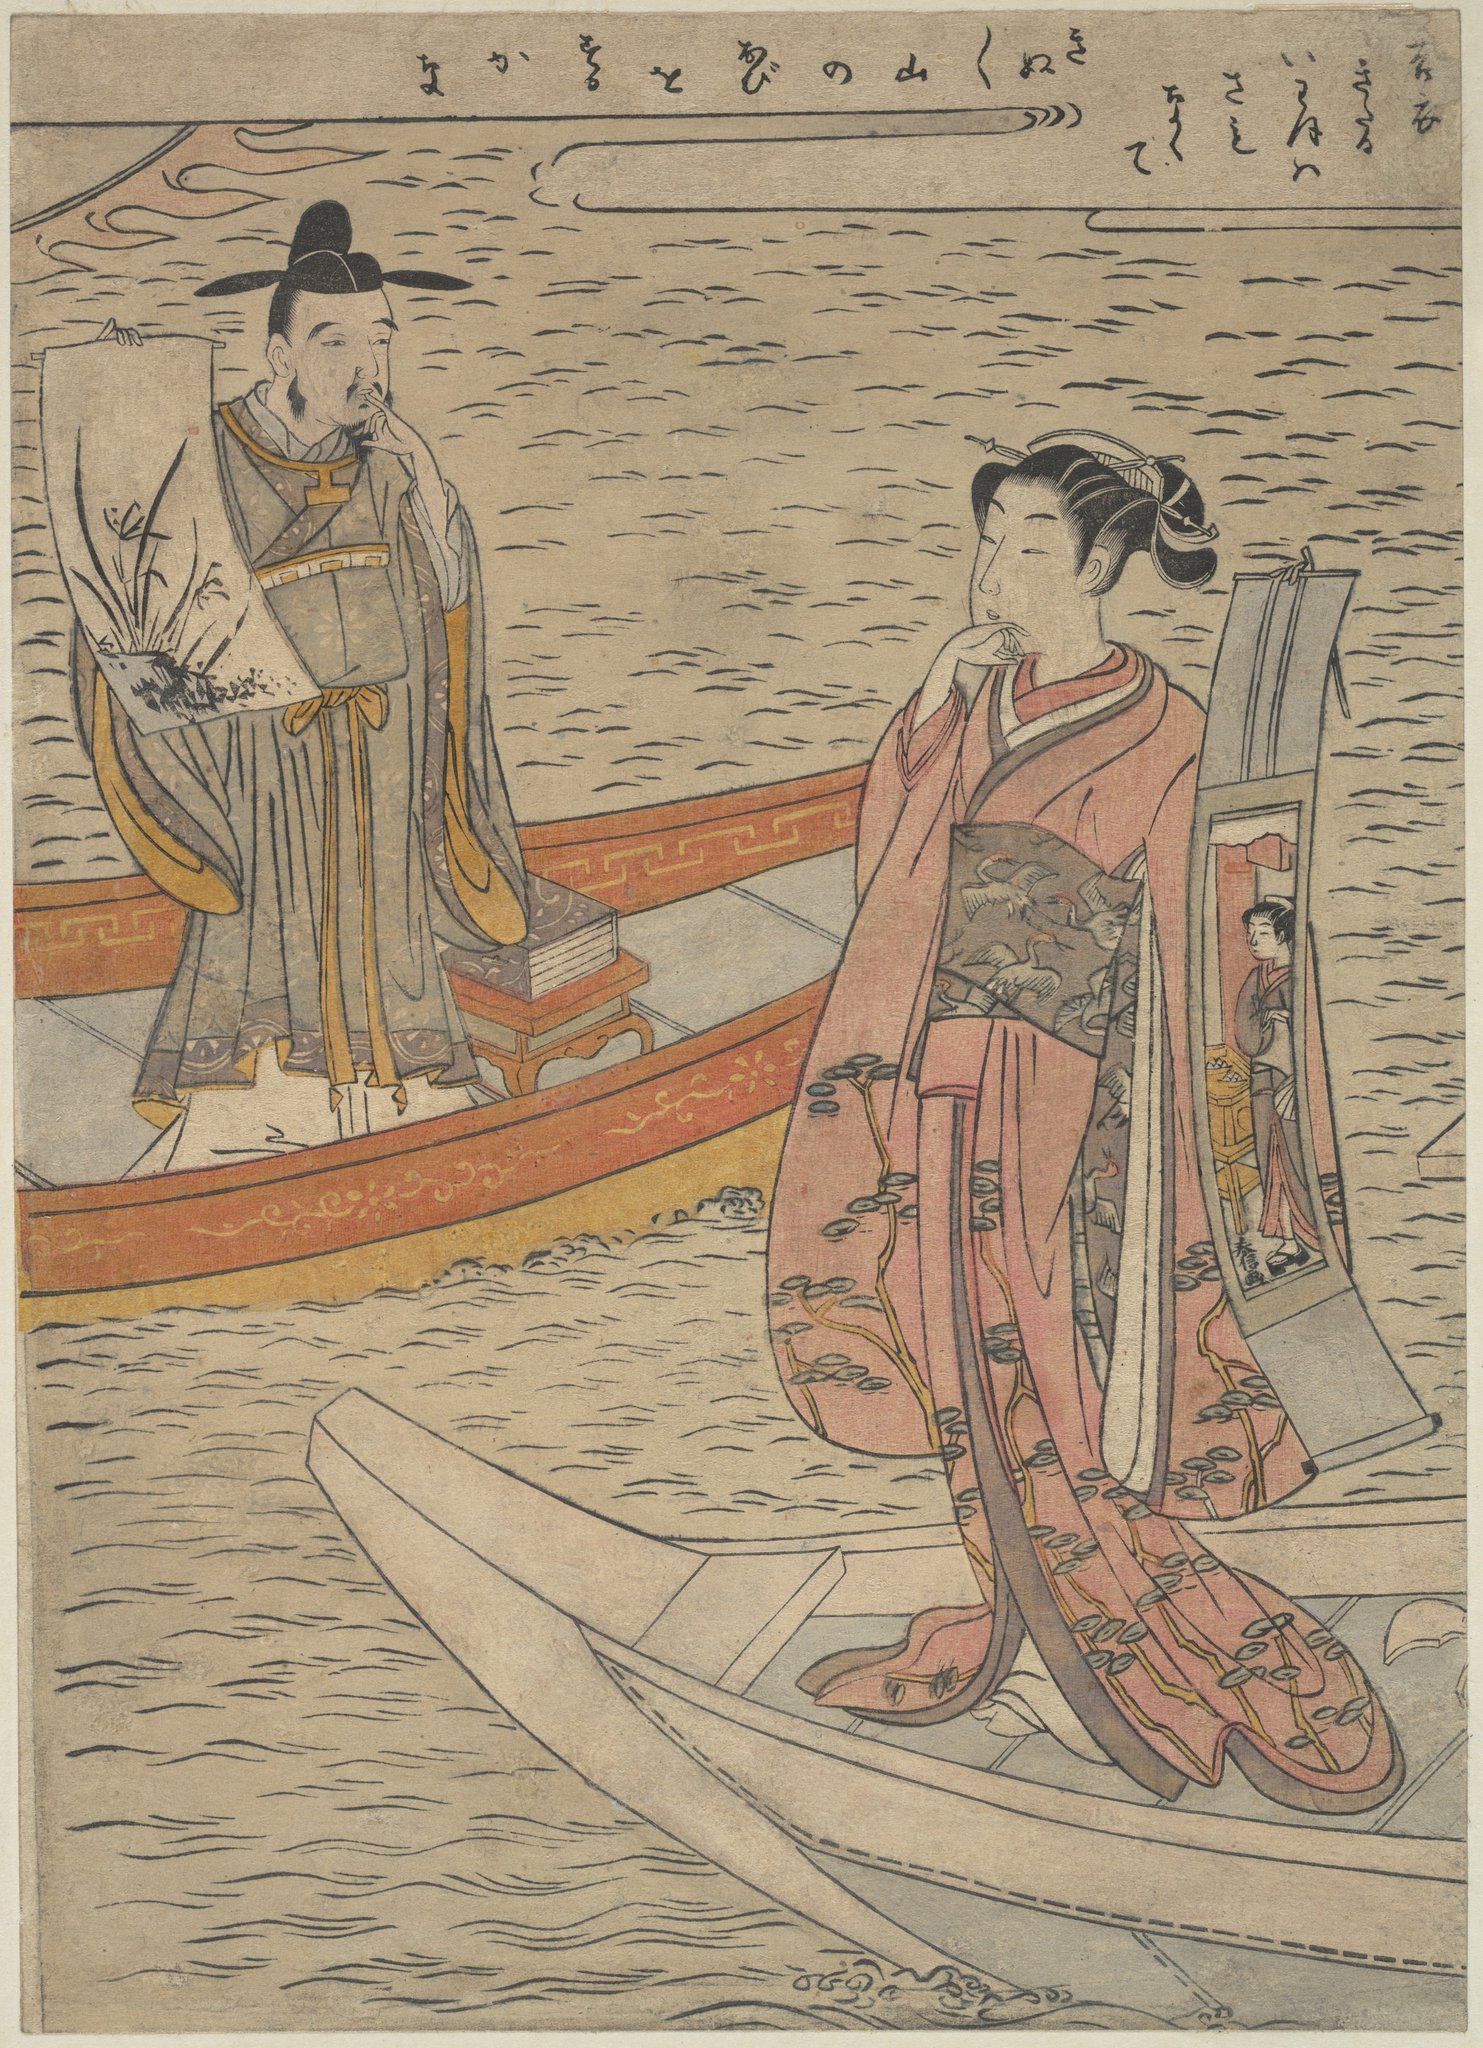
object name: print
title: Parody of the Noh Play "Hakurakuten"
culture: japanese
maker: suzuki harunobu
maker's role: artist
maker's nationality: japanese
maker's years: 1725-1770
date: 1766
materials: ink, paper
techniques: woodblock print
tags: men,women,actors,boats